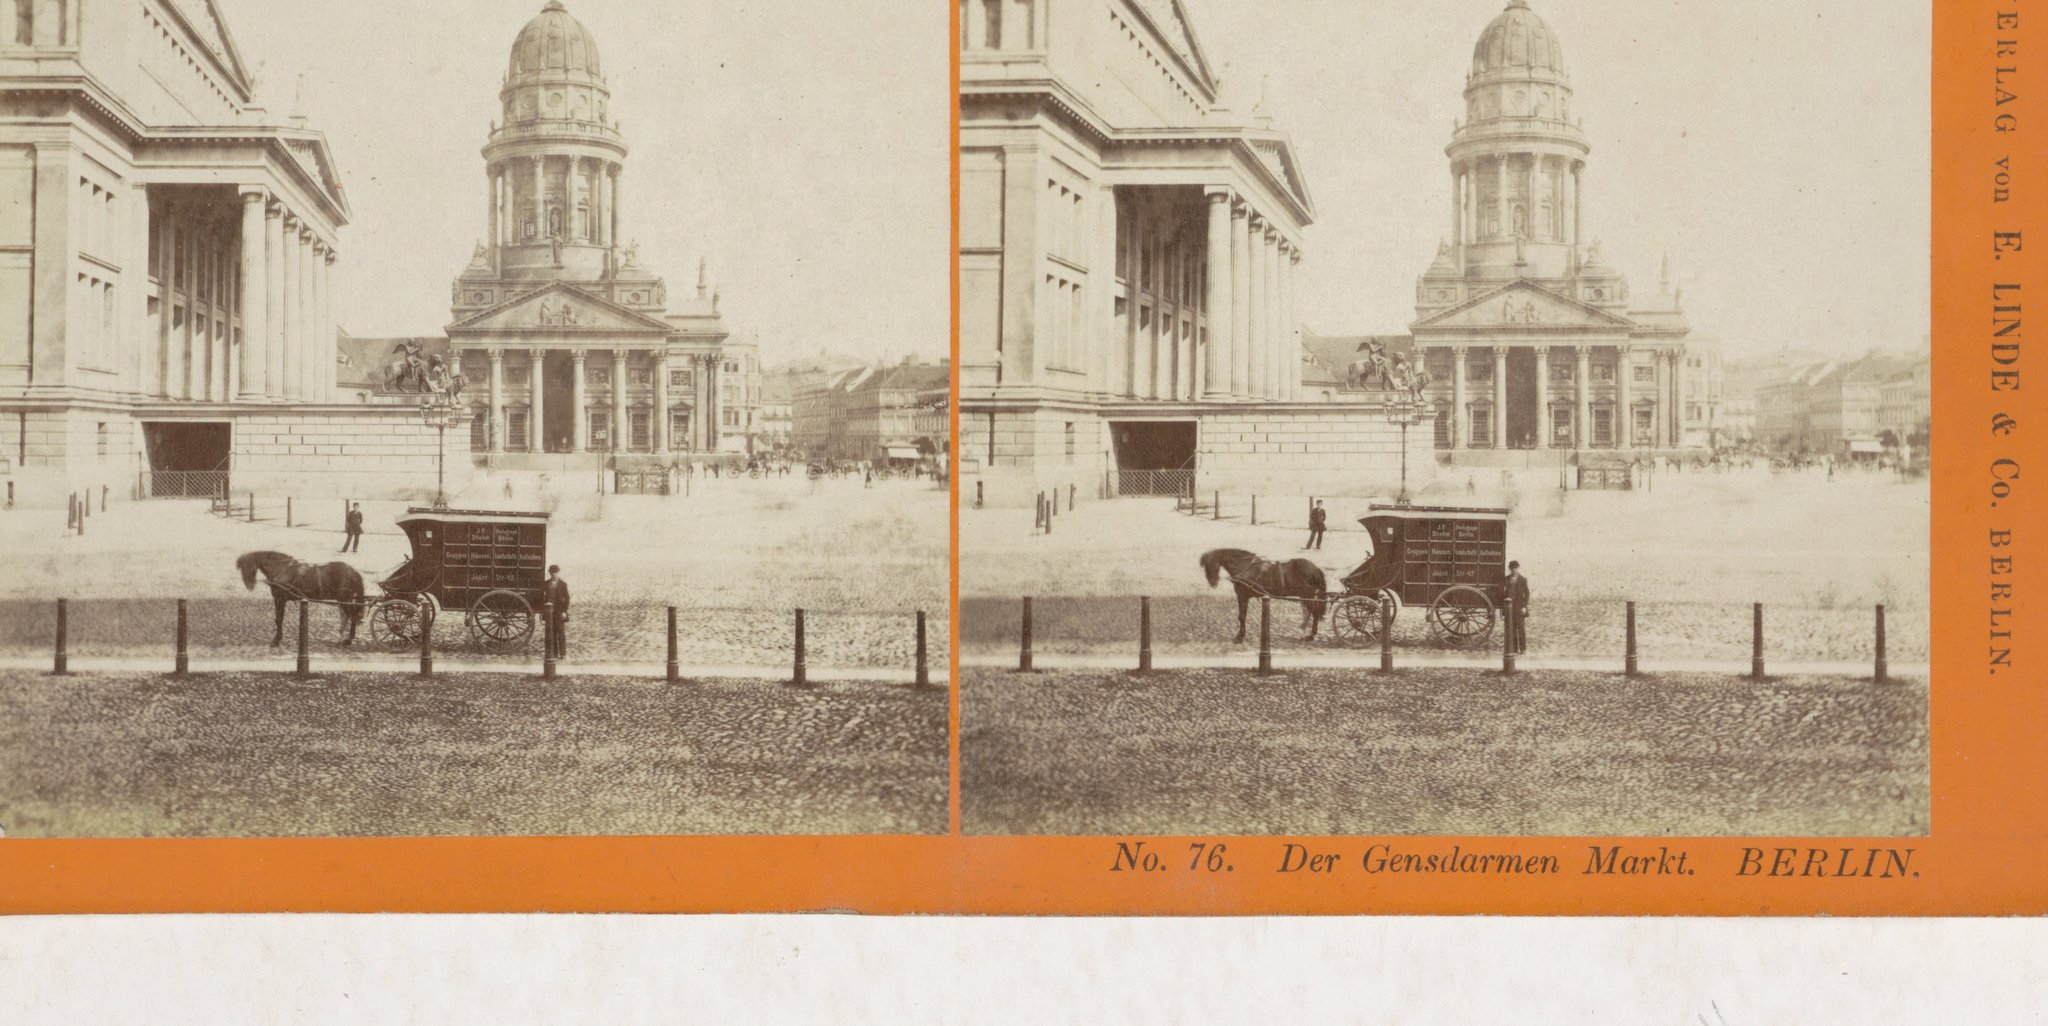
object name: stereograph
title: Gendarmenmarkt in Berlijn met de Französischer Dom en het Konzerthaus Berlin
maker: johann friedrich stiehm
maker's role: fotograaf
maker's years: 1826-1902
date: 1868-1870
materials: cardboard, paper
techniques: albumen print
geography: berlin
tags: square, place, circus, etc.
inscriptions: number: ‘No. 76.’